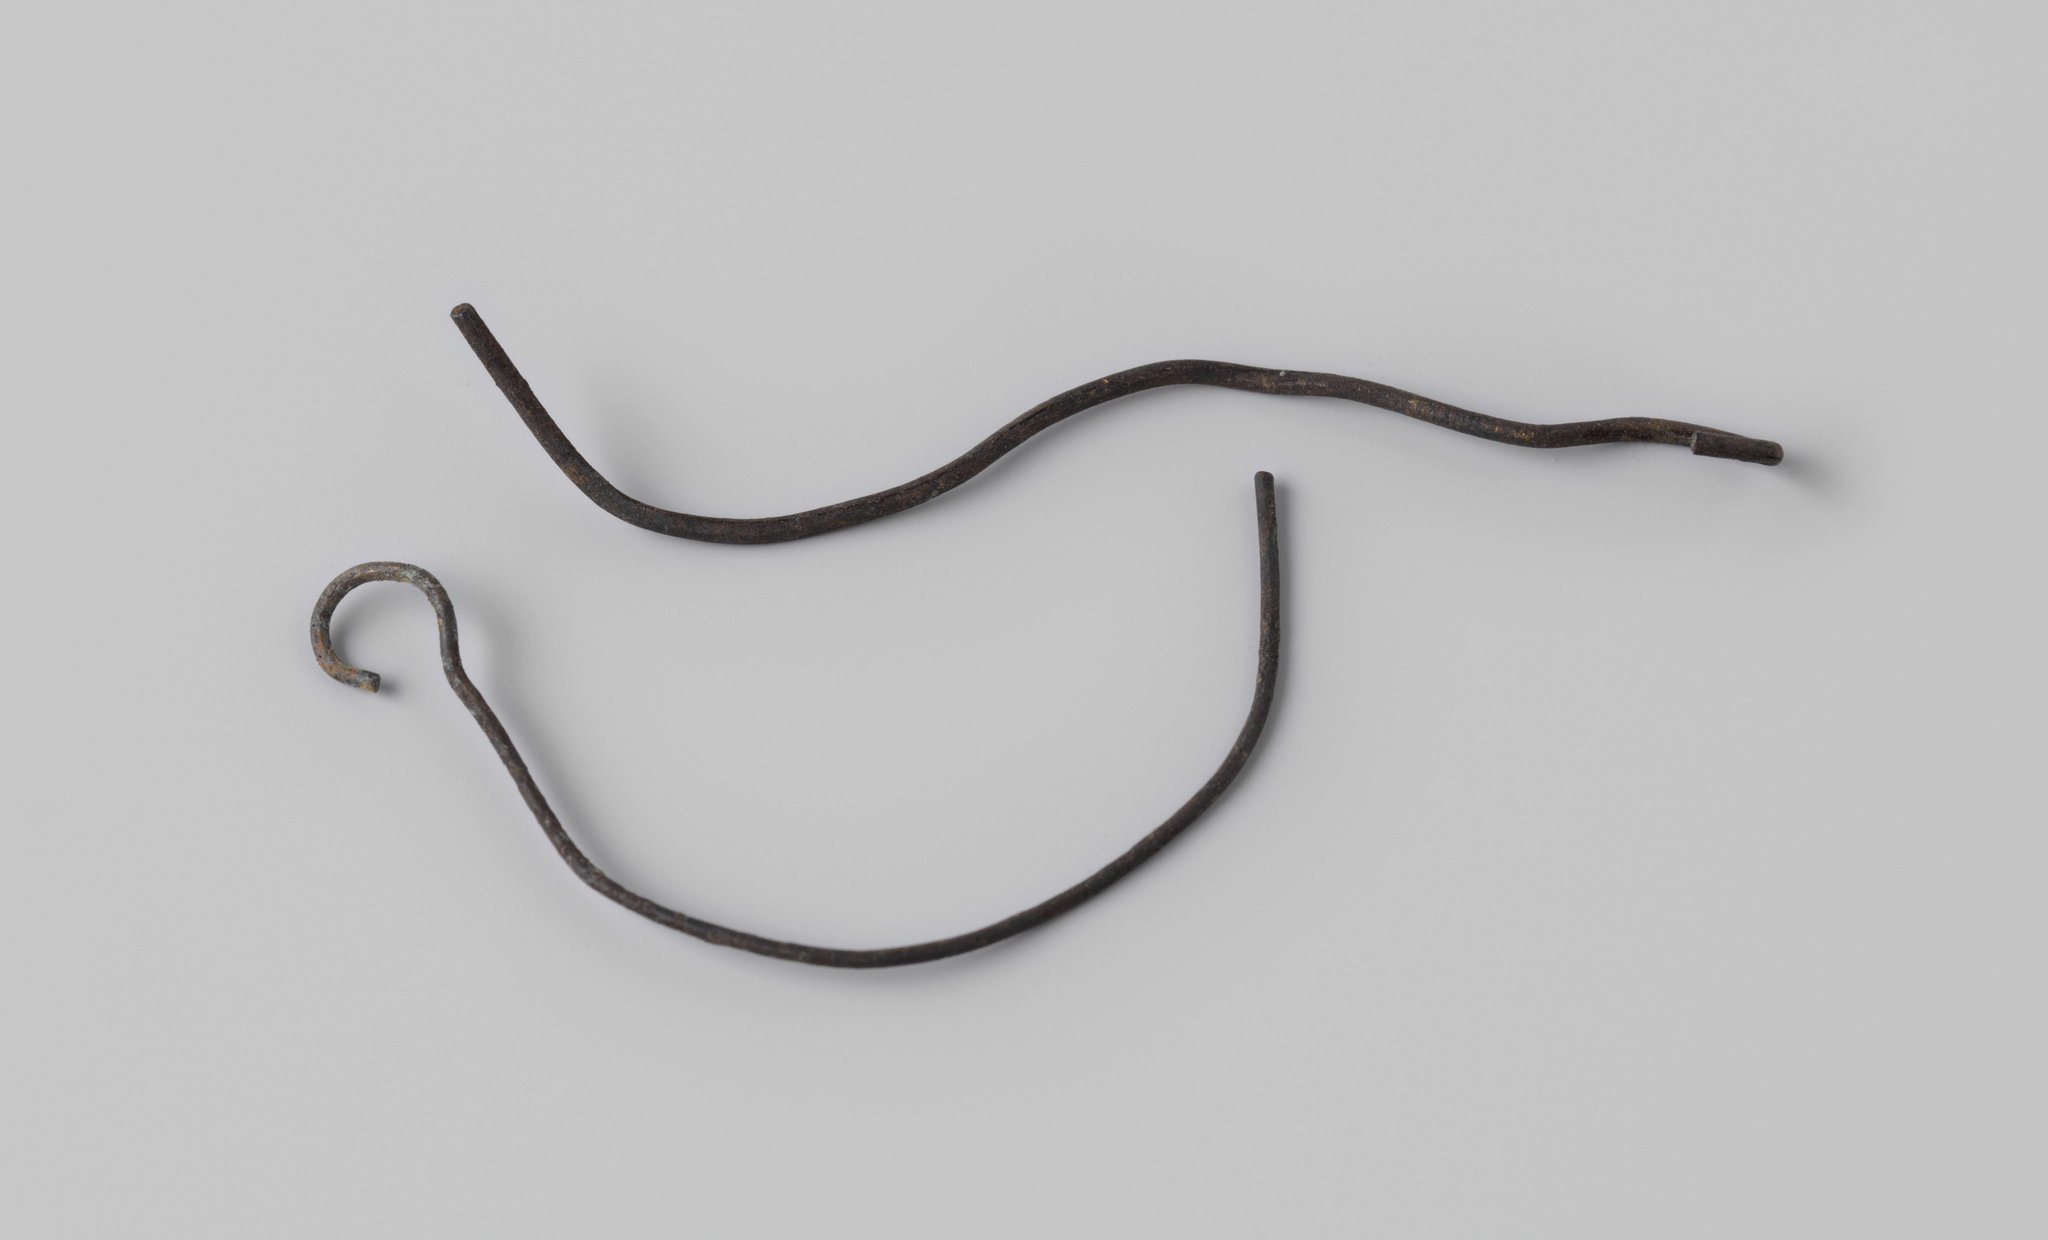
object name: wire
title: Fragmenten koperdraad uit het wrak van de Oost-Indiëvaarder Hollandia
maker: Anonymous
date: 1700-1743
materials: copper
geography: netherlands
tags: verenigde oostindische compagnie, hollandia (schip), annet